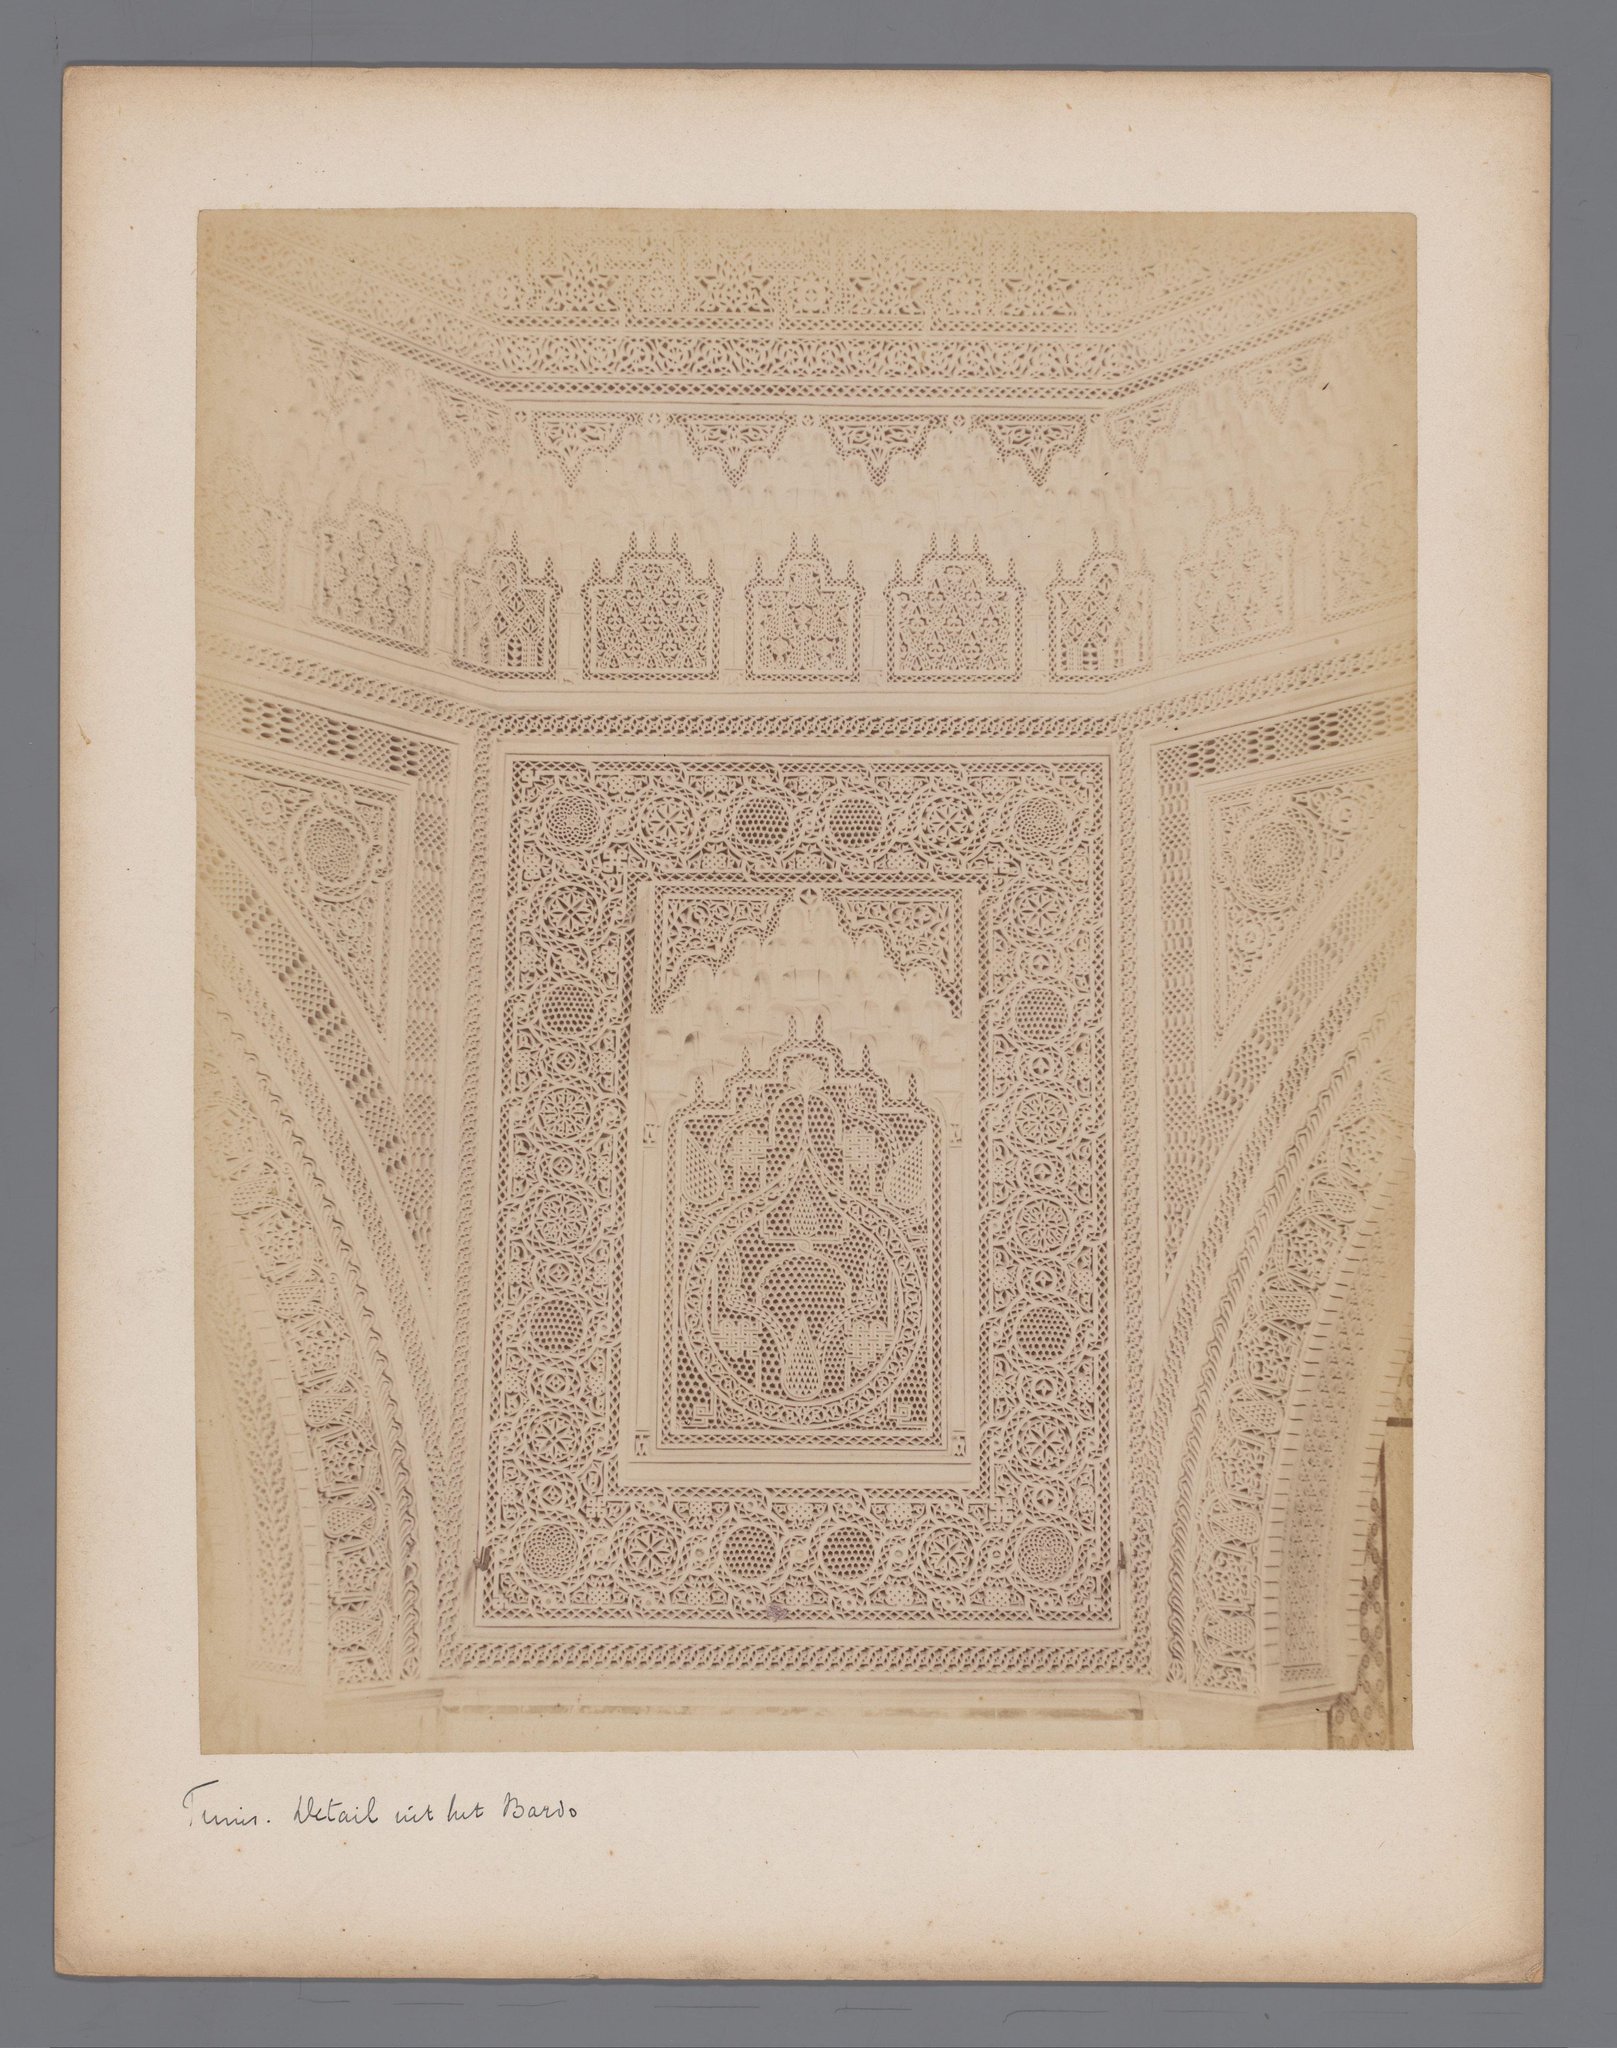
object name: photograph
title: Wand in het Bardomuseum in Le Bardo nabij Tunis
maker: Anonymous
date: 1888-1900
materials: cardboard, paper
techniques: albumen print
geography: le bardo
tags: decorations (interior of the house)